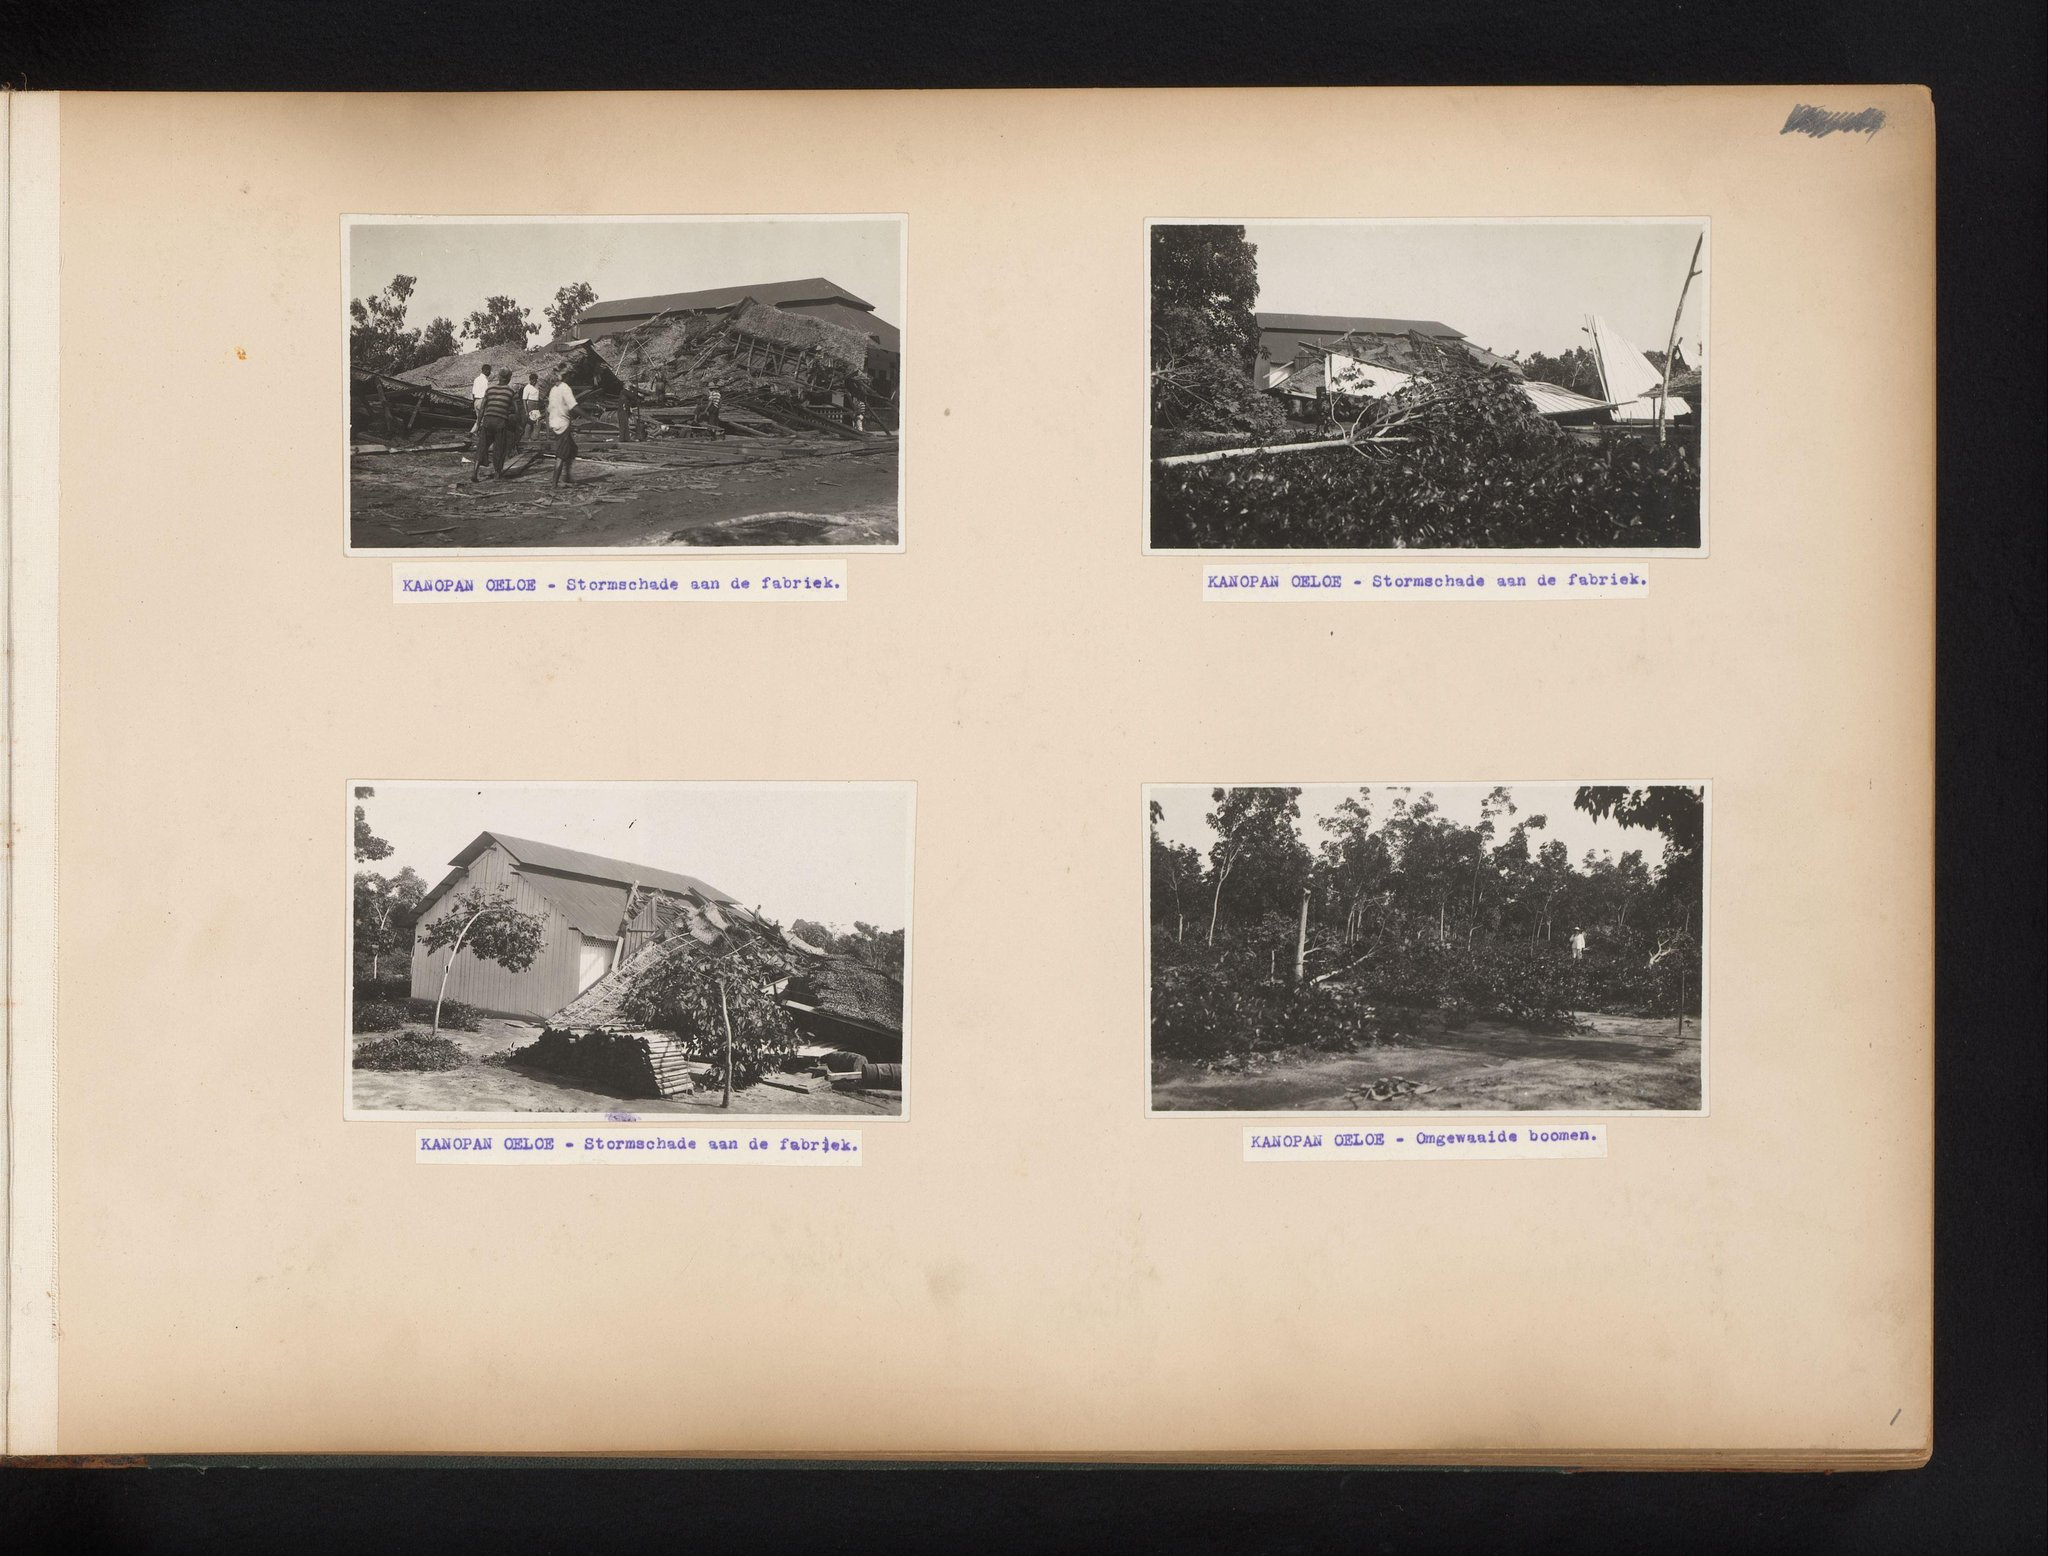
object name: photograph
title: Stormschade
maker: Anonymous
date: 1927-1931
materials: cardboard, photographic support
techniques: gelatin silver print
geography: sumatra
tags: plantation, (non-fruit) products of plants or trees: rubber, storm on land, sumatra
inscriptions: inscription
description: Blad met vier foto's van de stormschade aan de fabriek en rubberbomen op Kanopan Oeloe. Onderdeel van het fotoalbum over de plantages Leidong West en Kanopan Oeloe van de Cultuur Maatschappij Leidong West op Sumatra in de jaren 1925-1939.